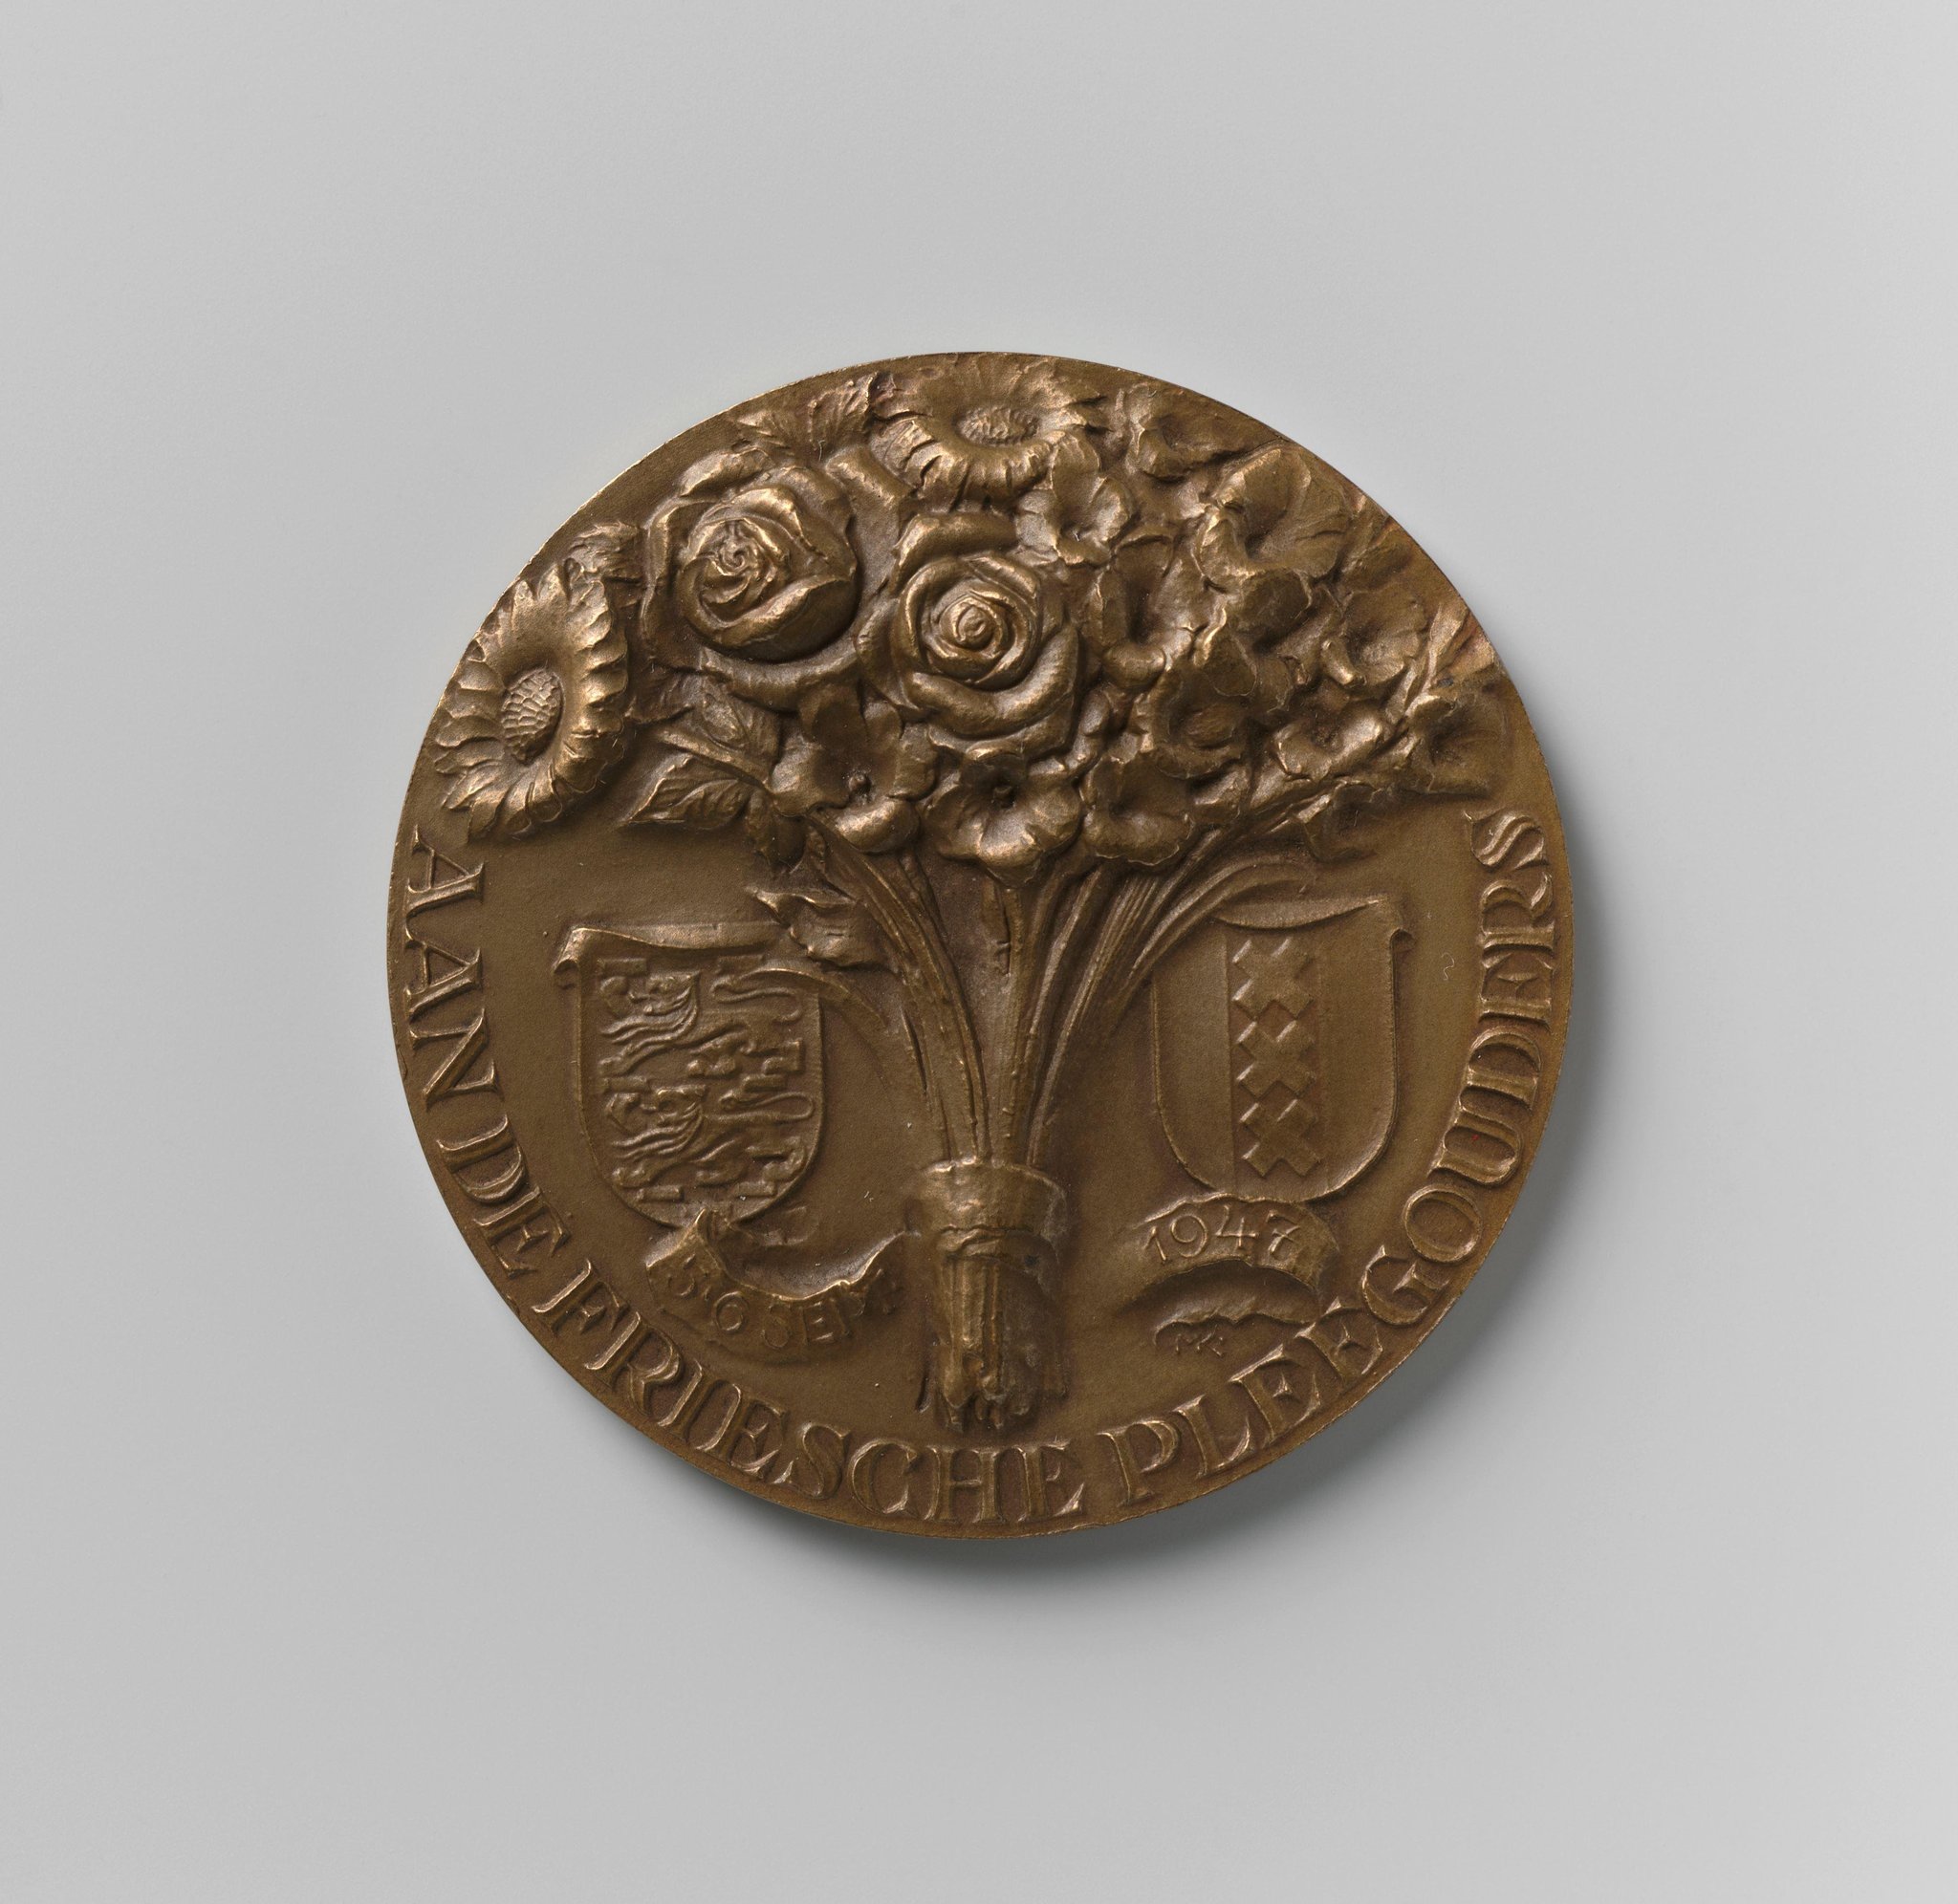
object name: history medal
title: Kinderuitzending naar Friese pleegouders door het Laboratorium Amsterdam van de Bataafsche Petroleum Maatschappij 1945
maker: marinus kutterink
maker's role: sculptor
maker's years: 1907-1983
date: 1945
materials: bronze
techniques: striking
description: Bronzen penning, op de voorzijde een samengestrikte bos bloemen tussen de wapenschilden van Friesland en Amsterdam, met onderaan omschrift, op de keerzijde zeven regels tekst met omschrift.